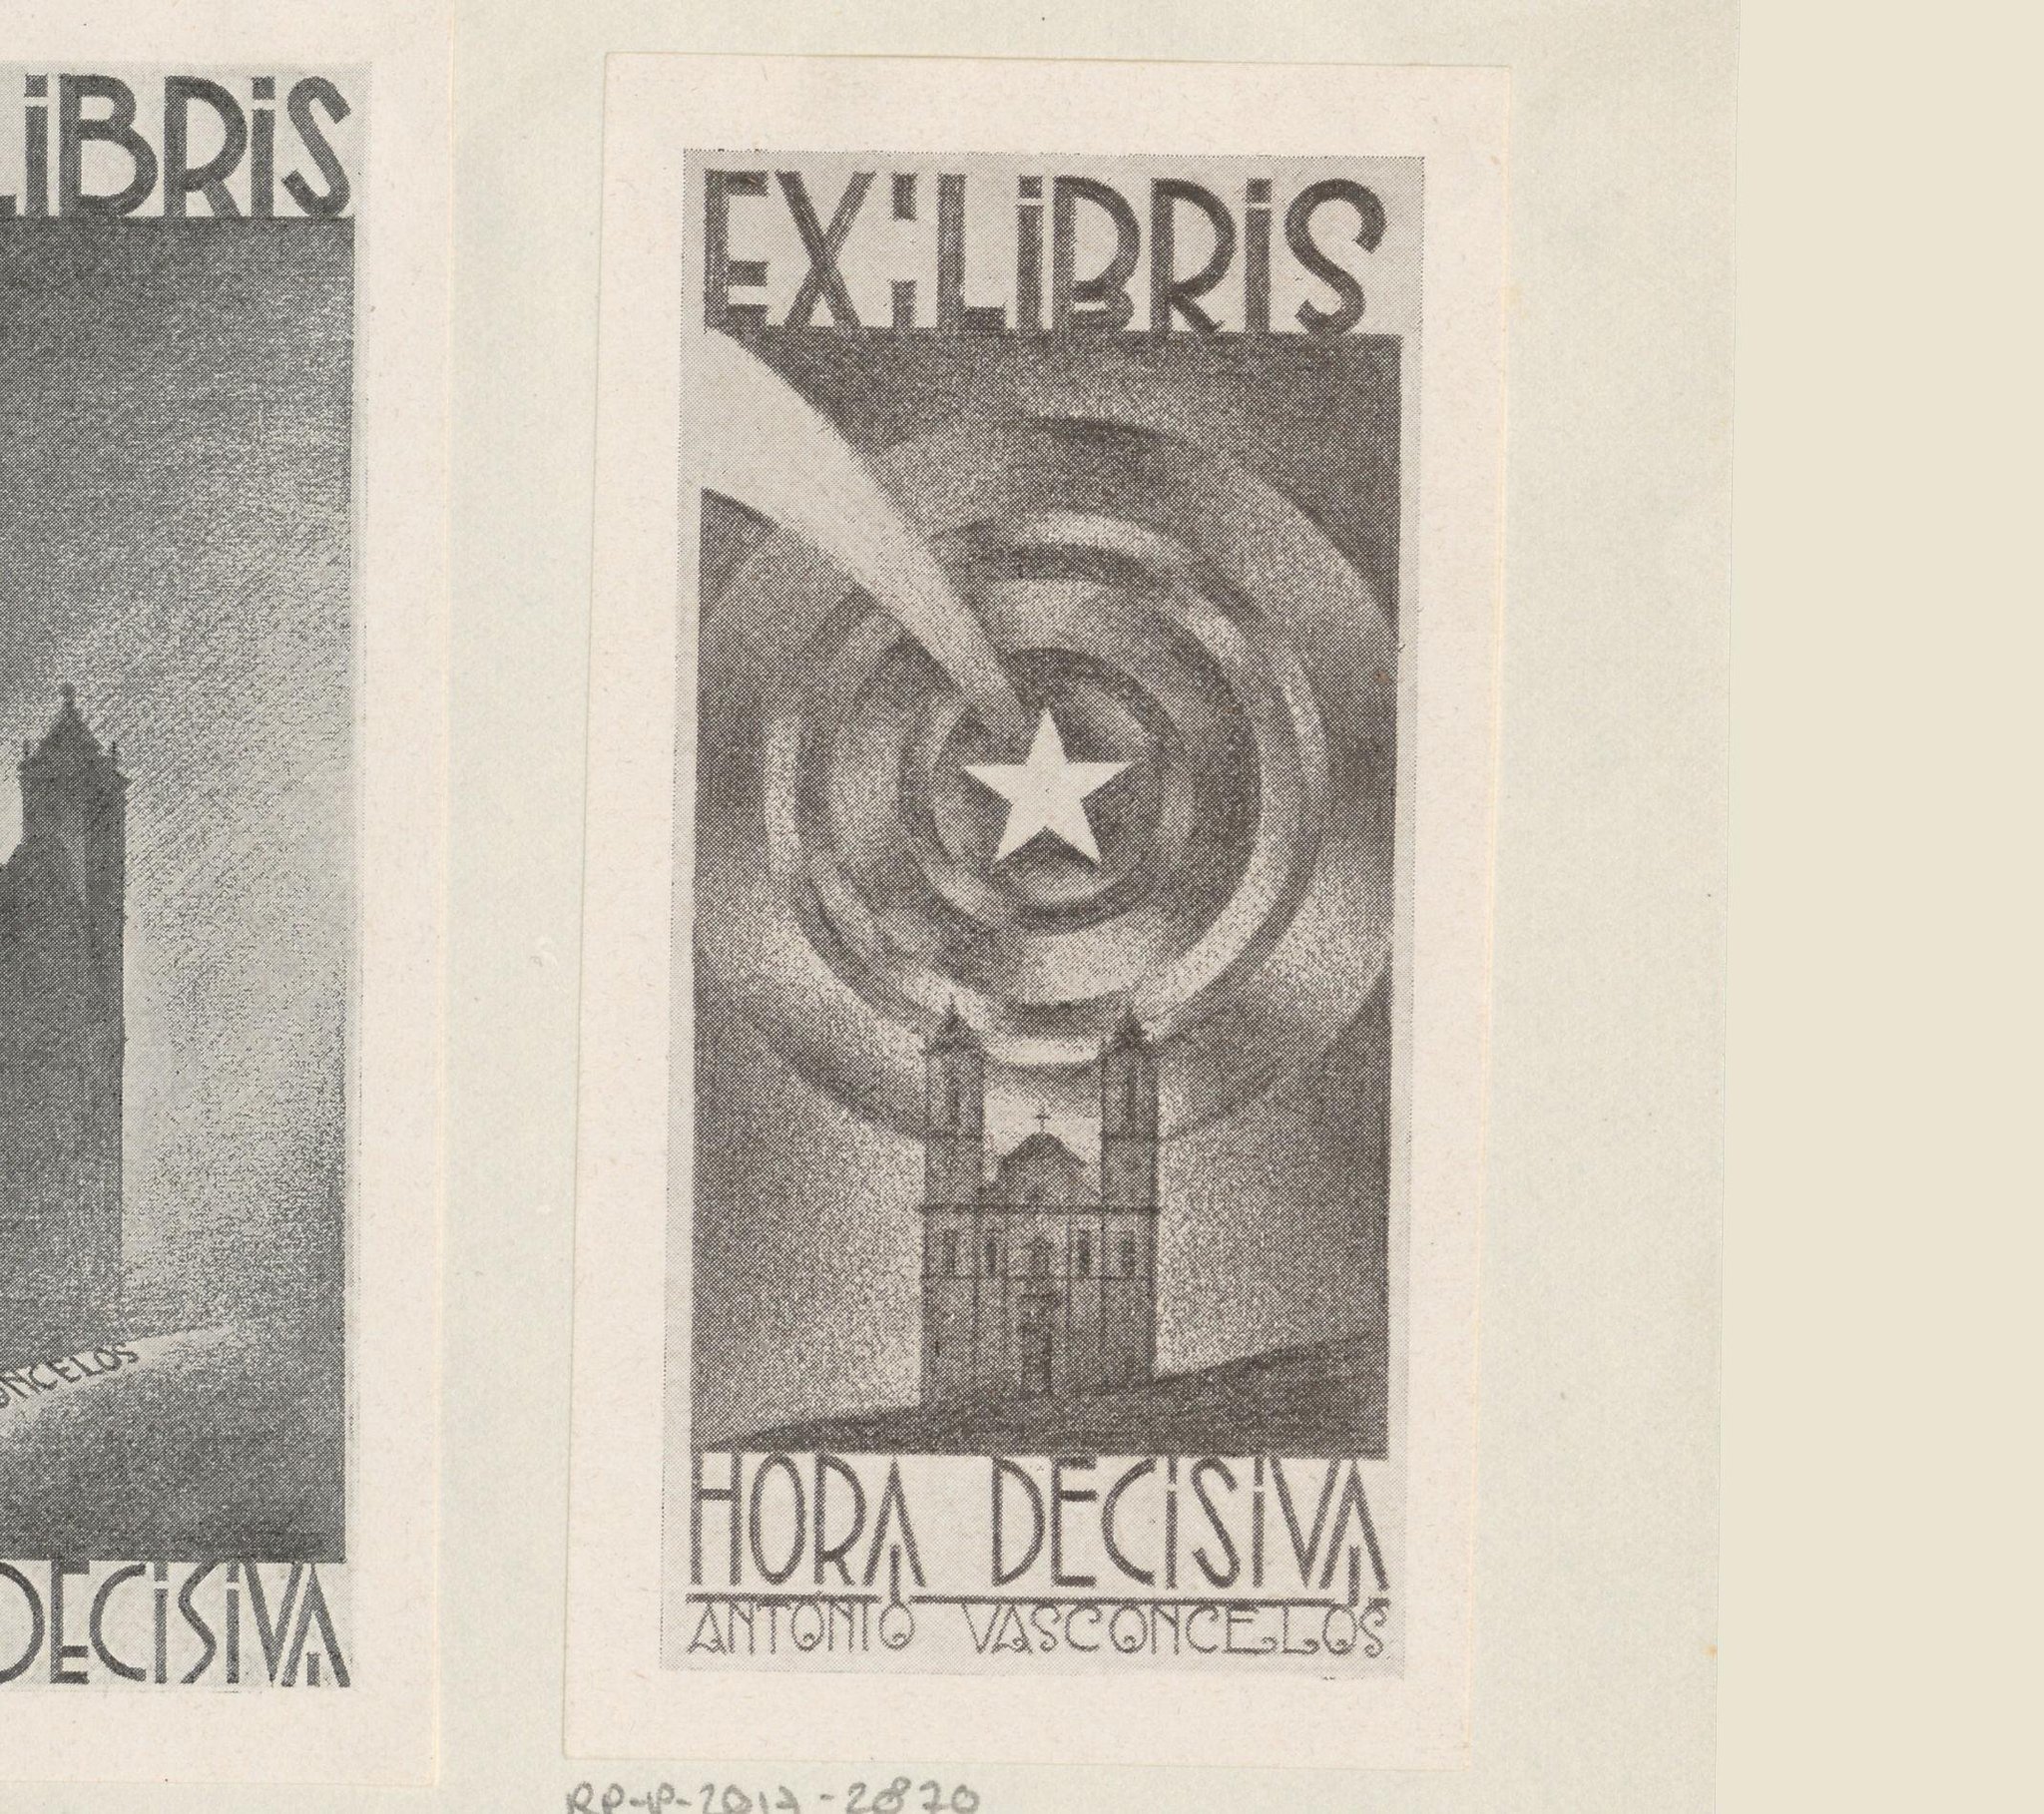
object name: bookplate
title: Hora decisiva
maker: Anonymous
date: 1900-1999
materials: paper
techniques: autotype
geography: portugal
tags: comet, roman catholic church